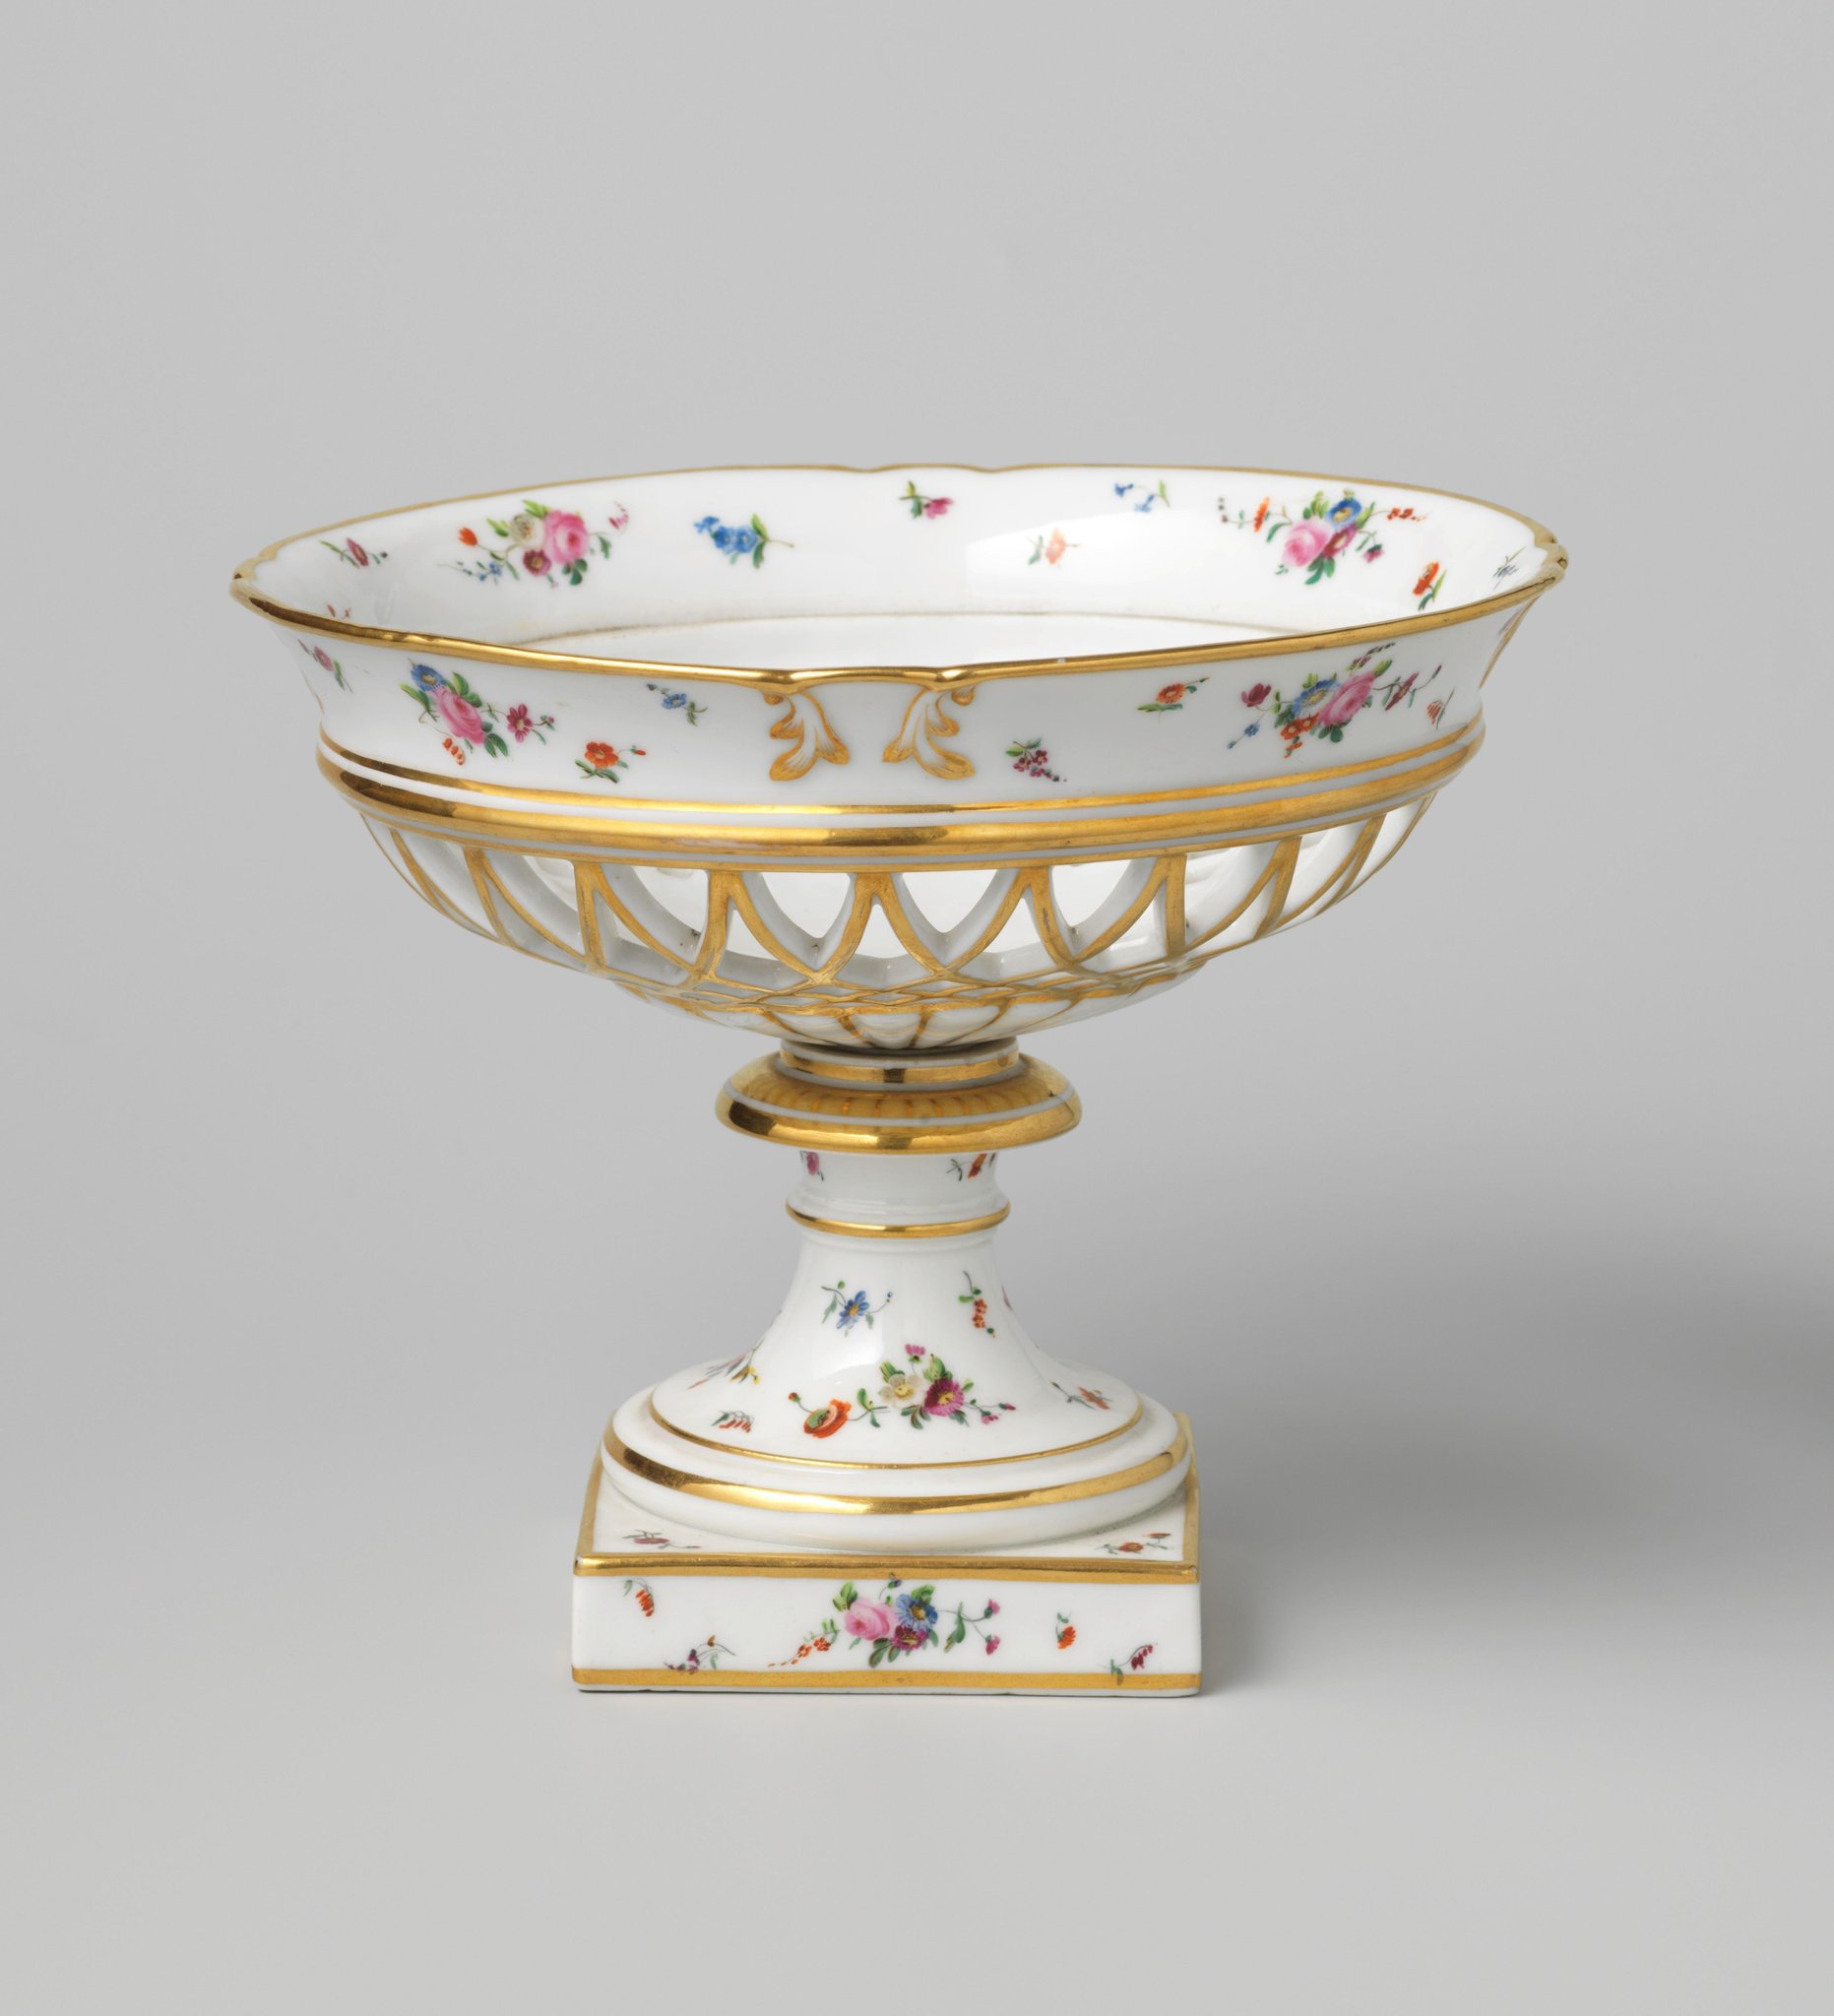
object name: fruit bowl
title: Dish on foot with bouquets and flower sprays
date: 1839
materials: glaze, gold, paint, porcelain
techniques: embroidery, firing, forming, gilding, turning, vitrification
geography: paris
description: Schaal (fruitschaal) op hoge voet van porselein met een gelobde rand, beschilderd op het glazuur in blauw, rood, roze, groen, geel, paars, zwart en goud. Het onderste deel van de wand is opengewerkt en de ronde voet loopt door in een vierkant voetstuk. Versierd met boeketten van verschillende bloemen, strooibloemen en gouden lijnen. De schaal met vanuit de gelobde, gouden rand, gemodelleerde bladranken op de buitenwand, aangezet met goud. De pin om de delen te verbinden ontbreekt.